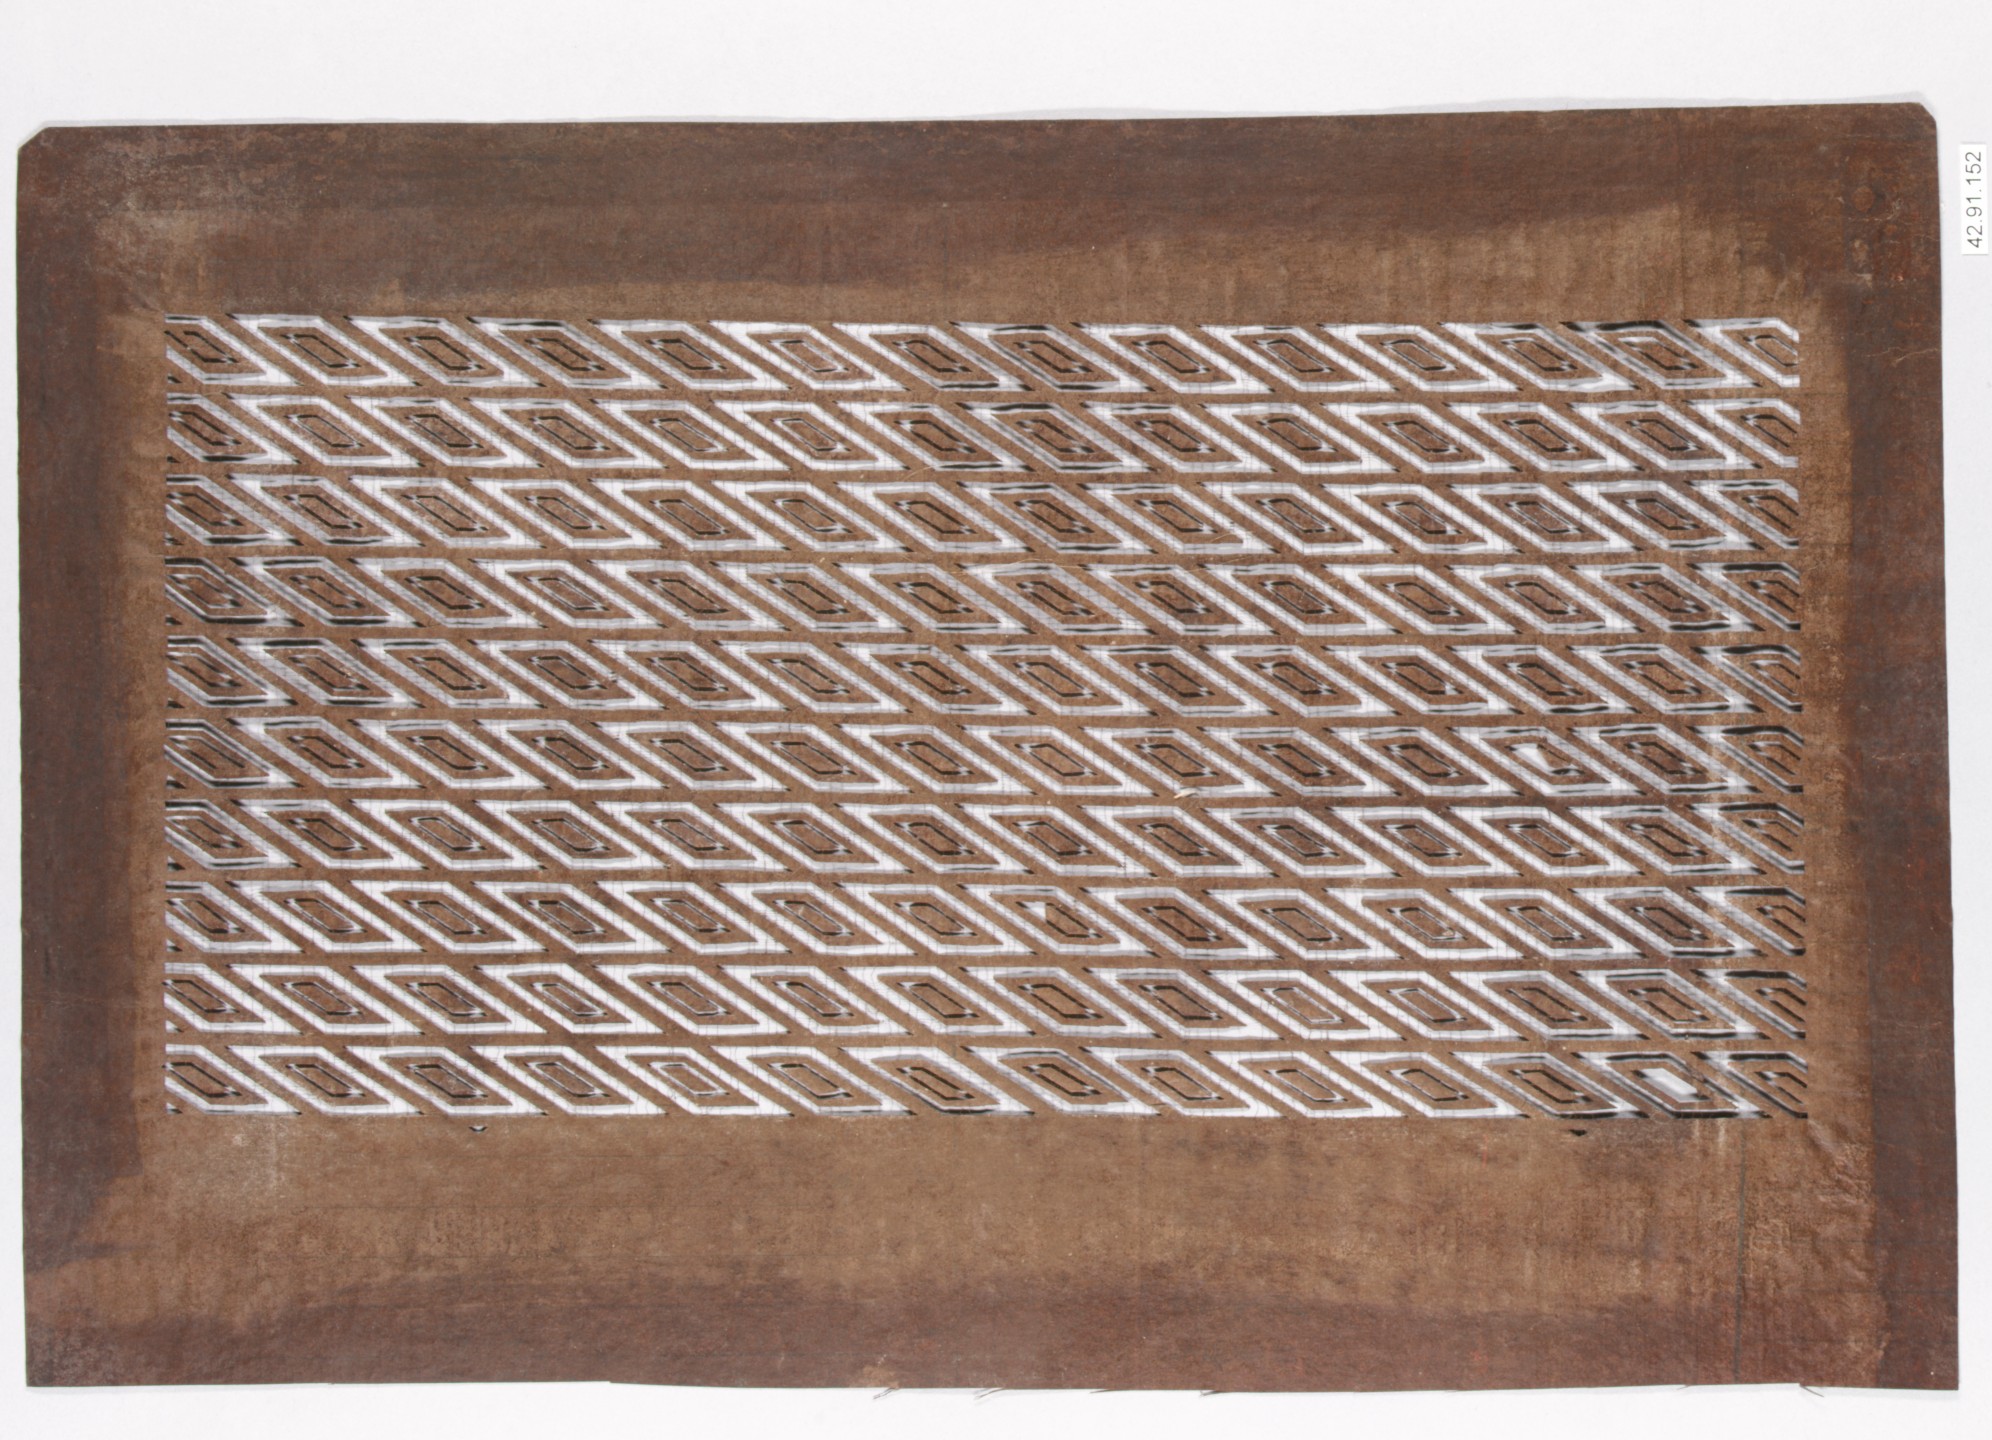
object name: stencil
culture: japanese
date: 1801-1900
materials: paper